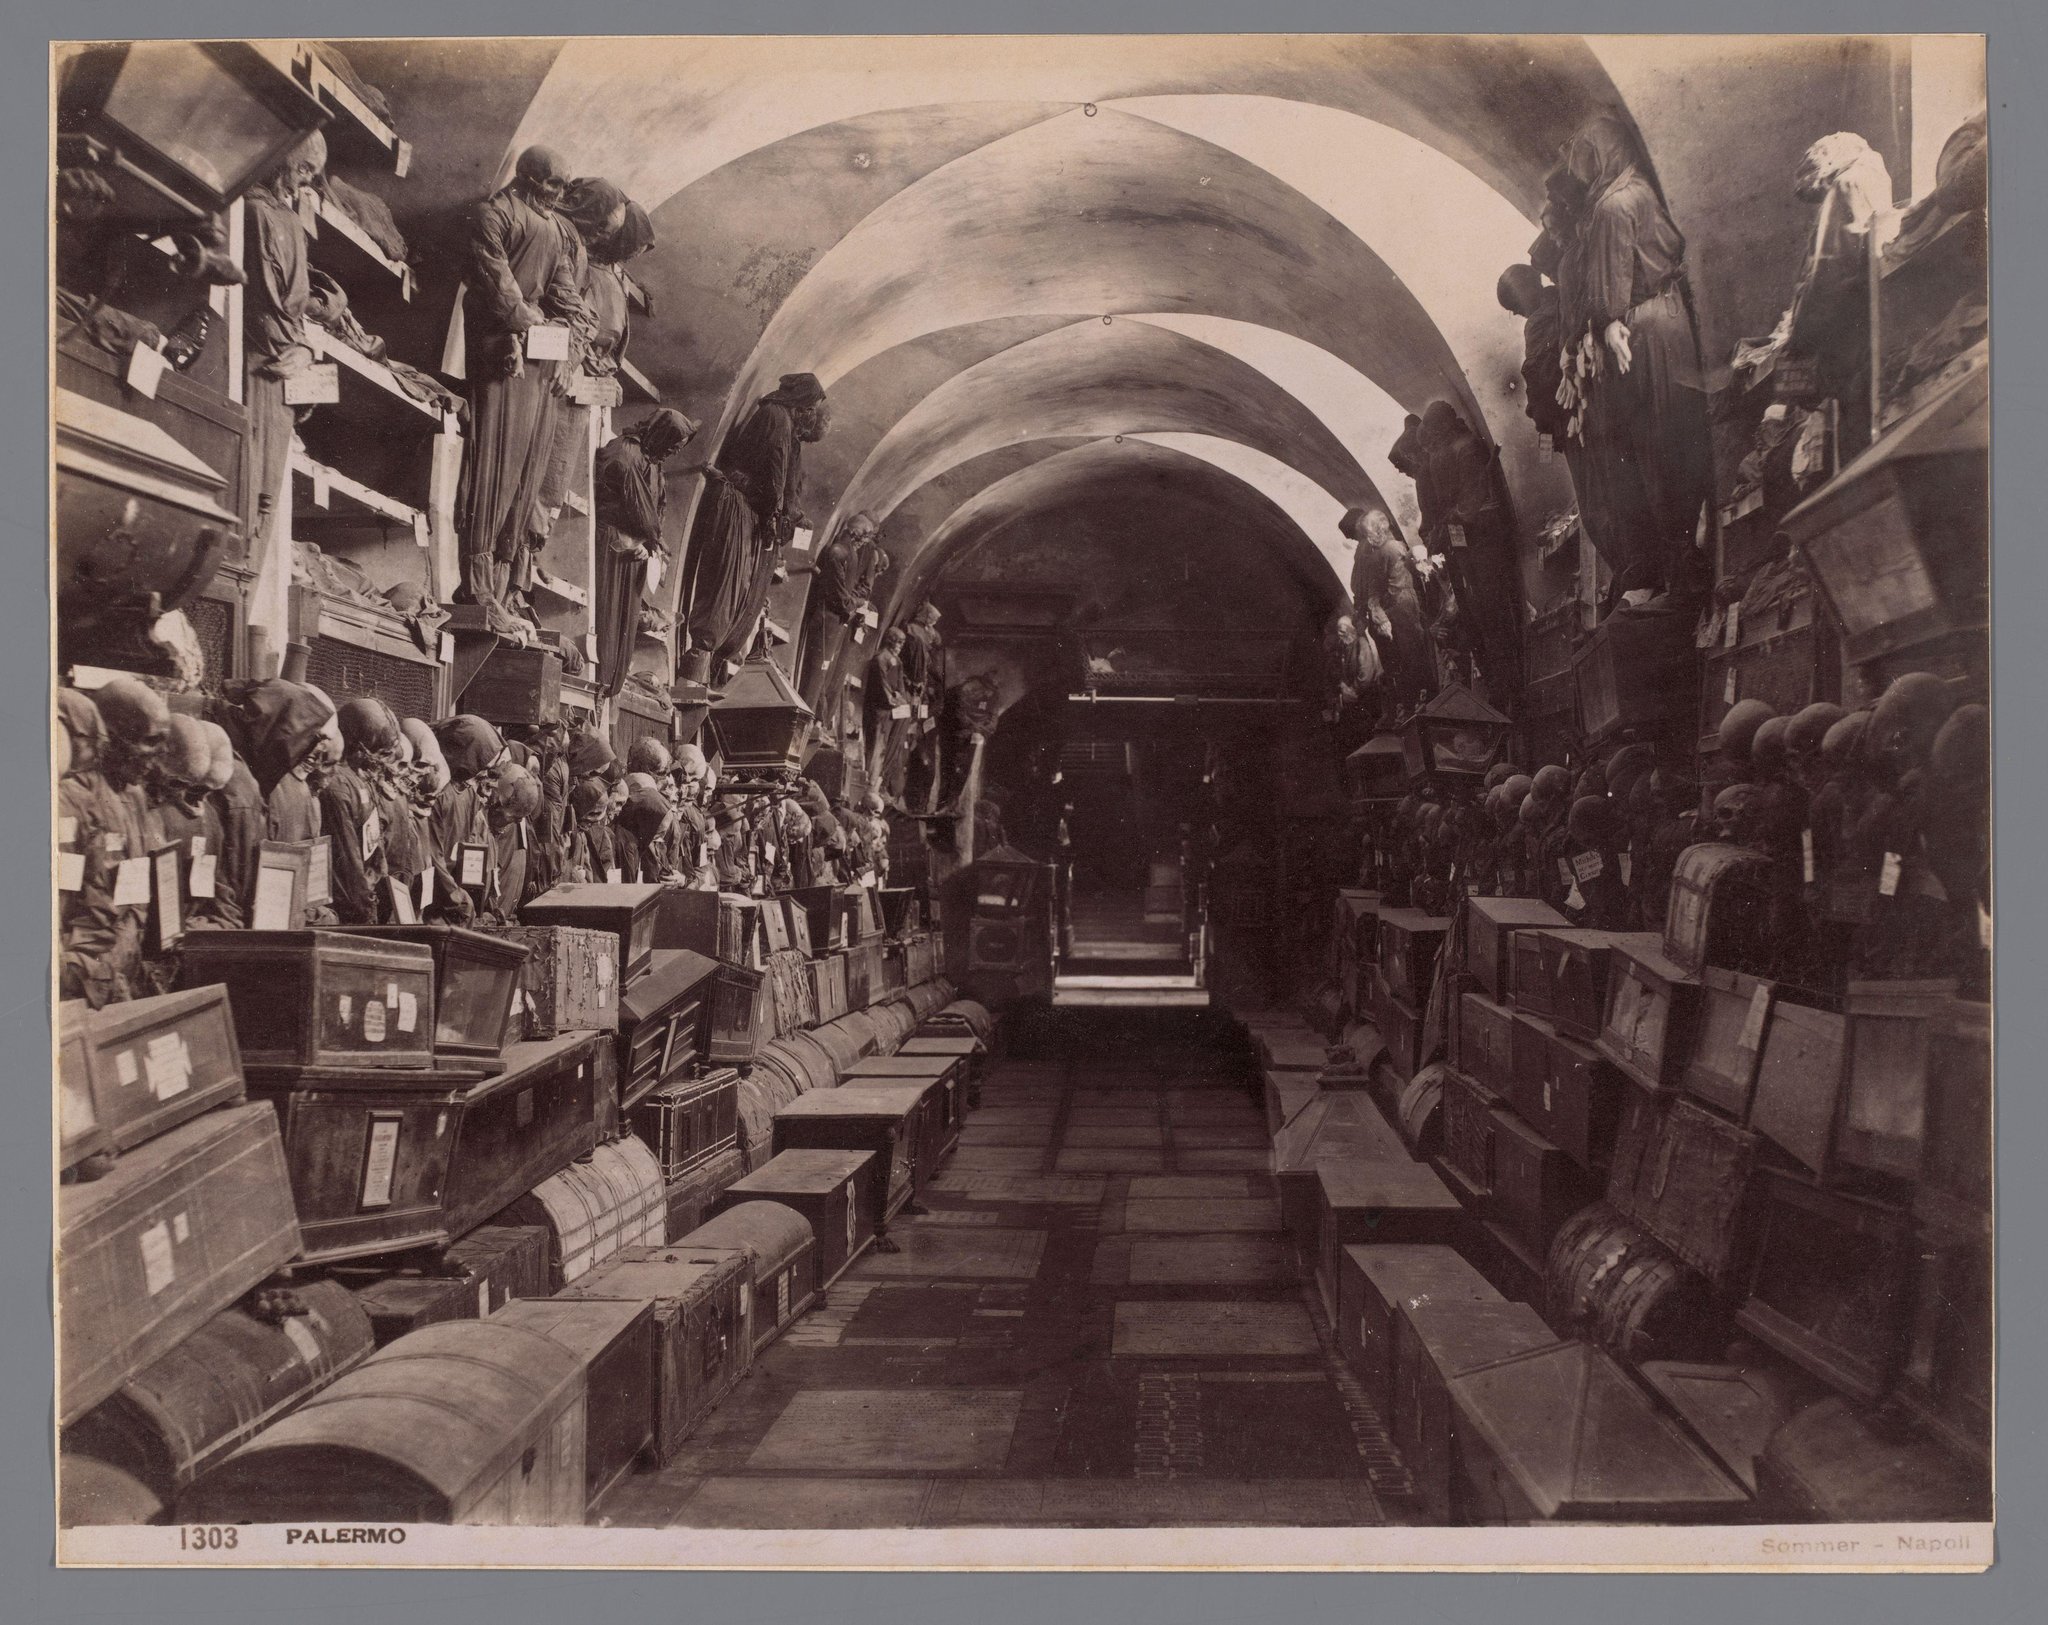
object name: photograph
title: Interieur van de crypte van de kapucijnen te Palermo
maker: giorgio sommer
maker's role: fotograaf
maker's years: 1834-1914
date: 1857-1914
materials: cardboard, paper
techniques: albumen print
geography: palermo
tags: catacombs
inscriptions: number: ‘1303’, inscription: ‘Palermo/ Catacombe dei Cappuccini’